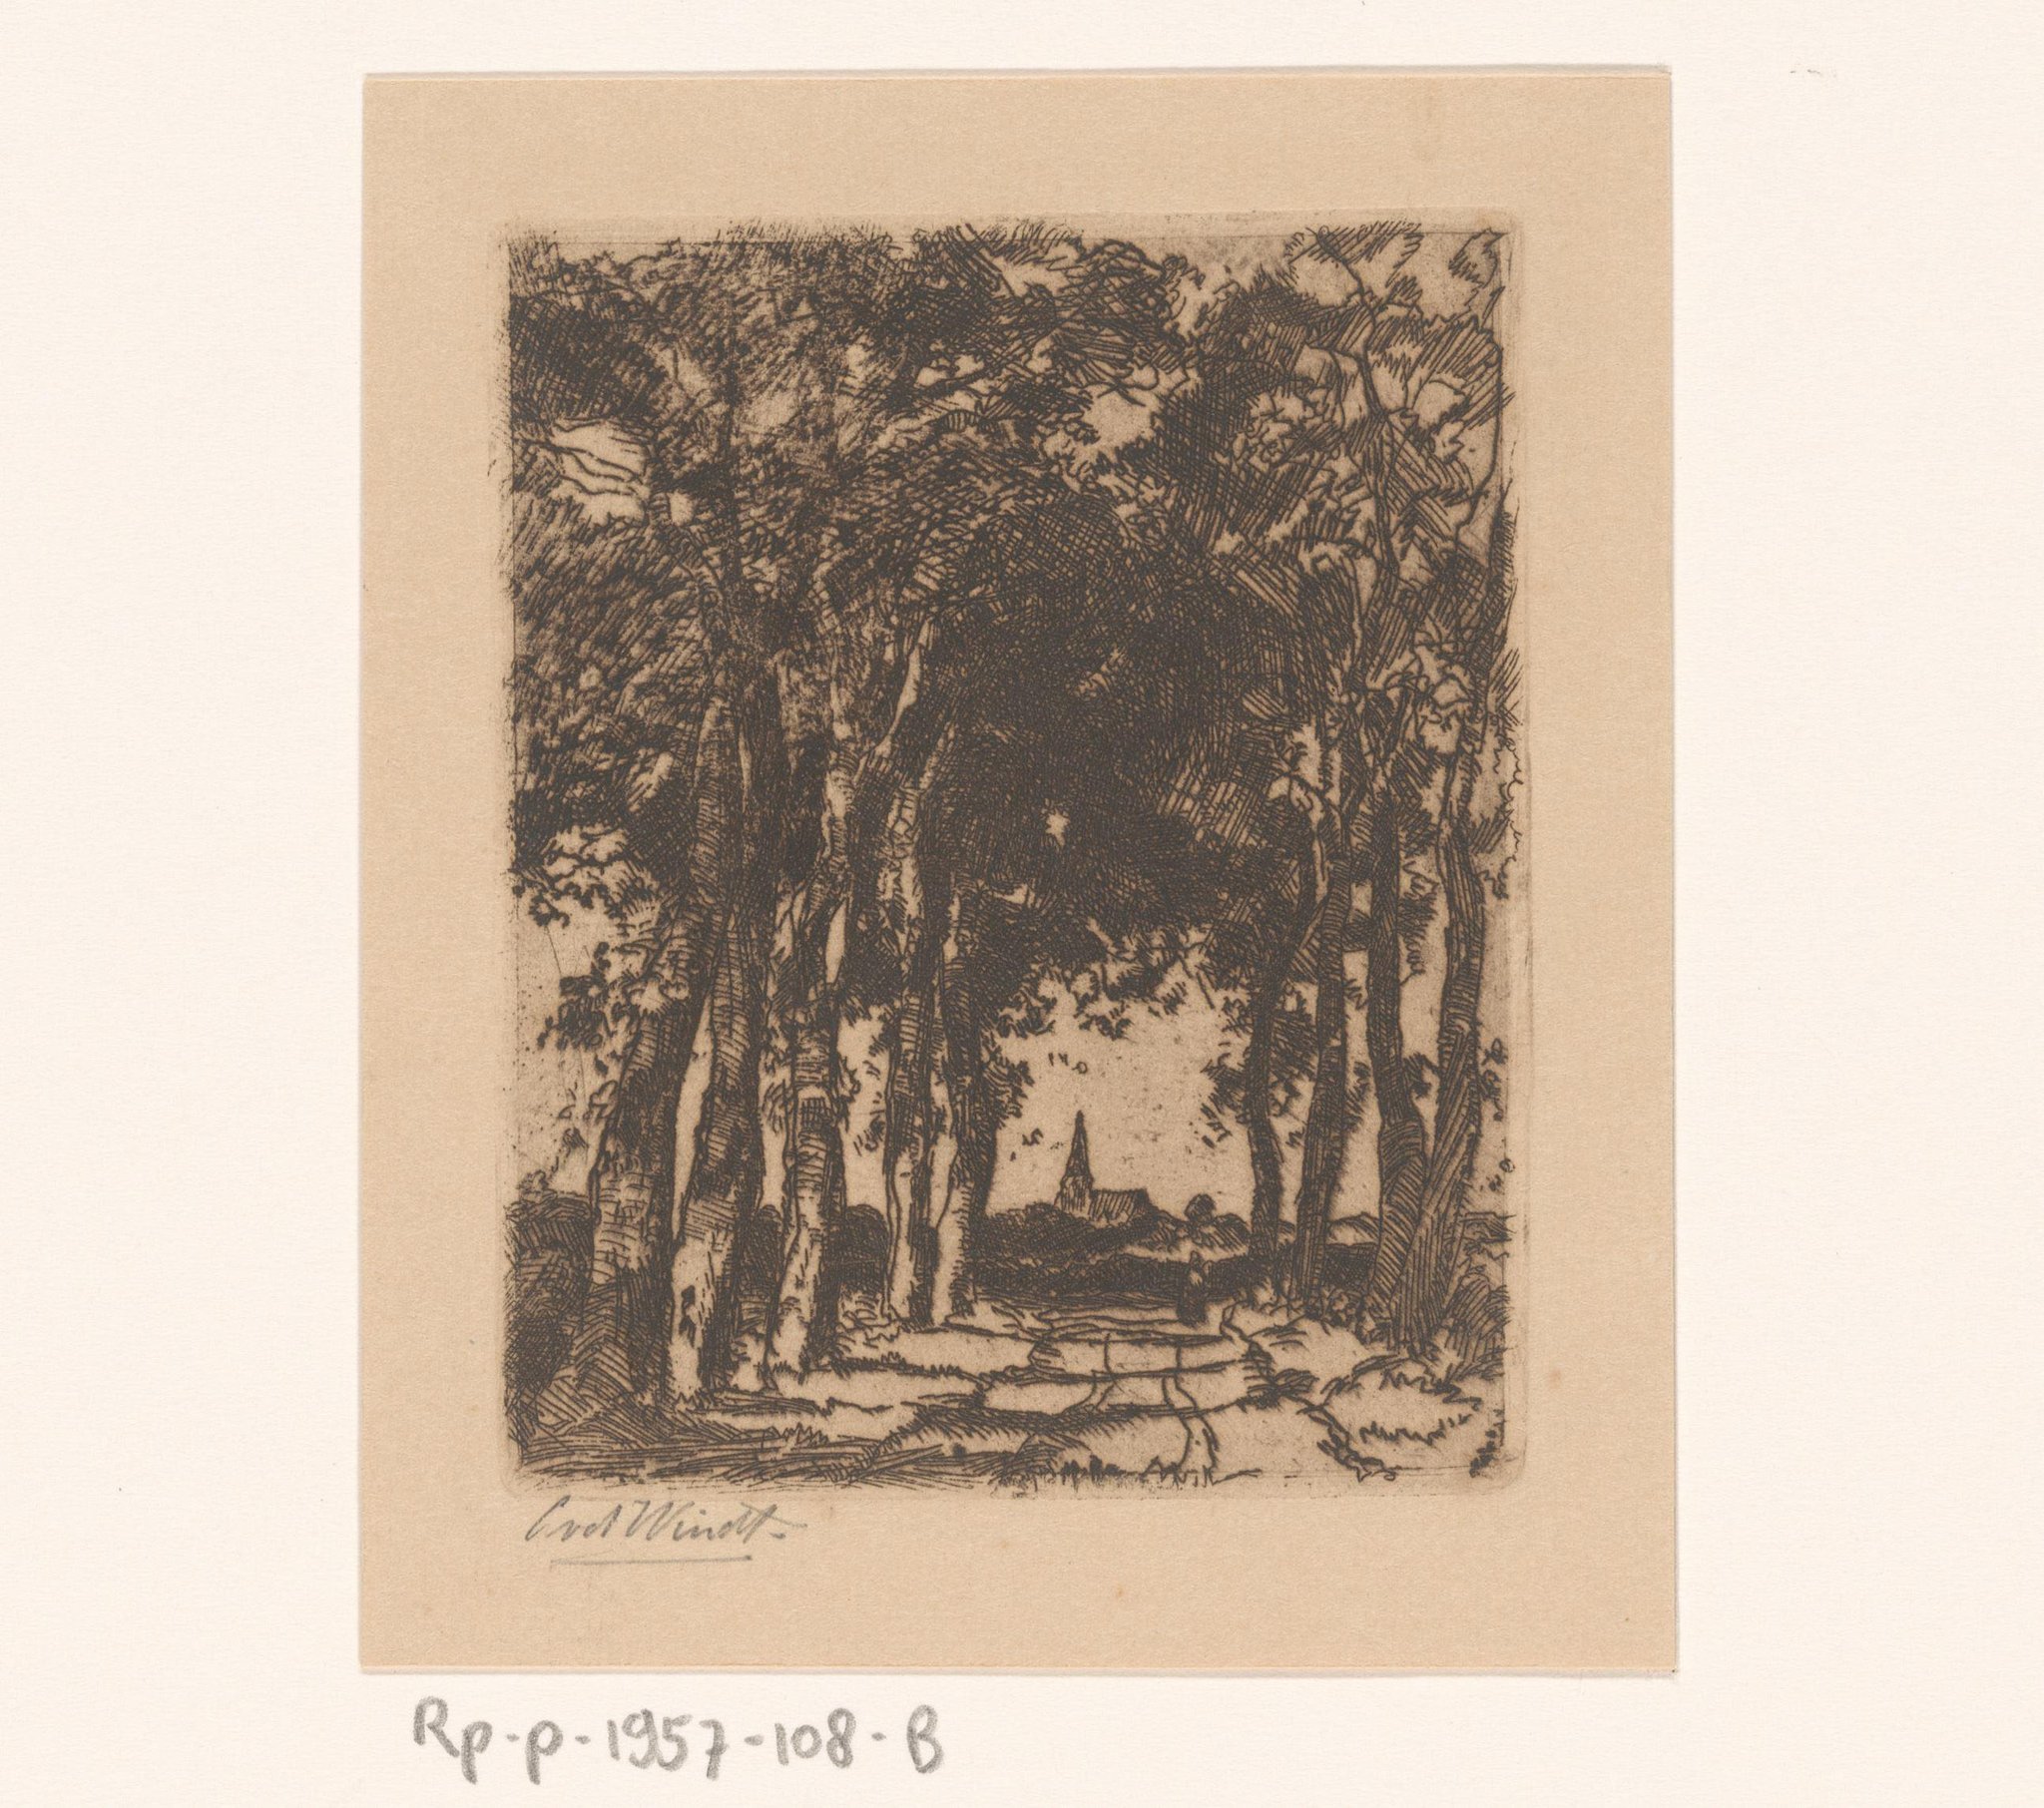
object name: print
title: Bomenlaan met dorpsgezicht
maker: chris van der windt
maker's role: print maker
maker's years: 1877-1952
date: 1887-1952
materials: paper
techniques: etching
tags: prospect of village, silhouette of village, forest path or lane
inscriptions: collector's mark: Lugt 2228